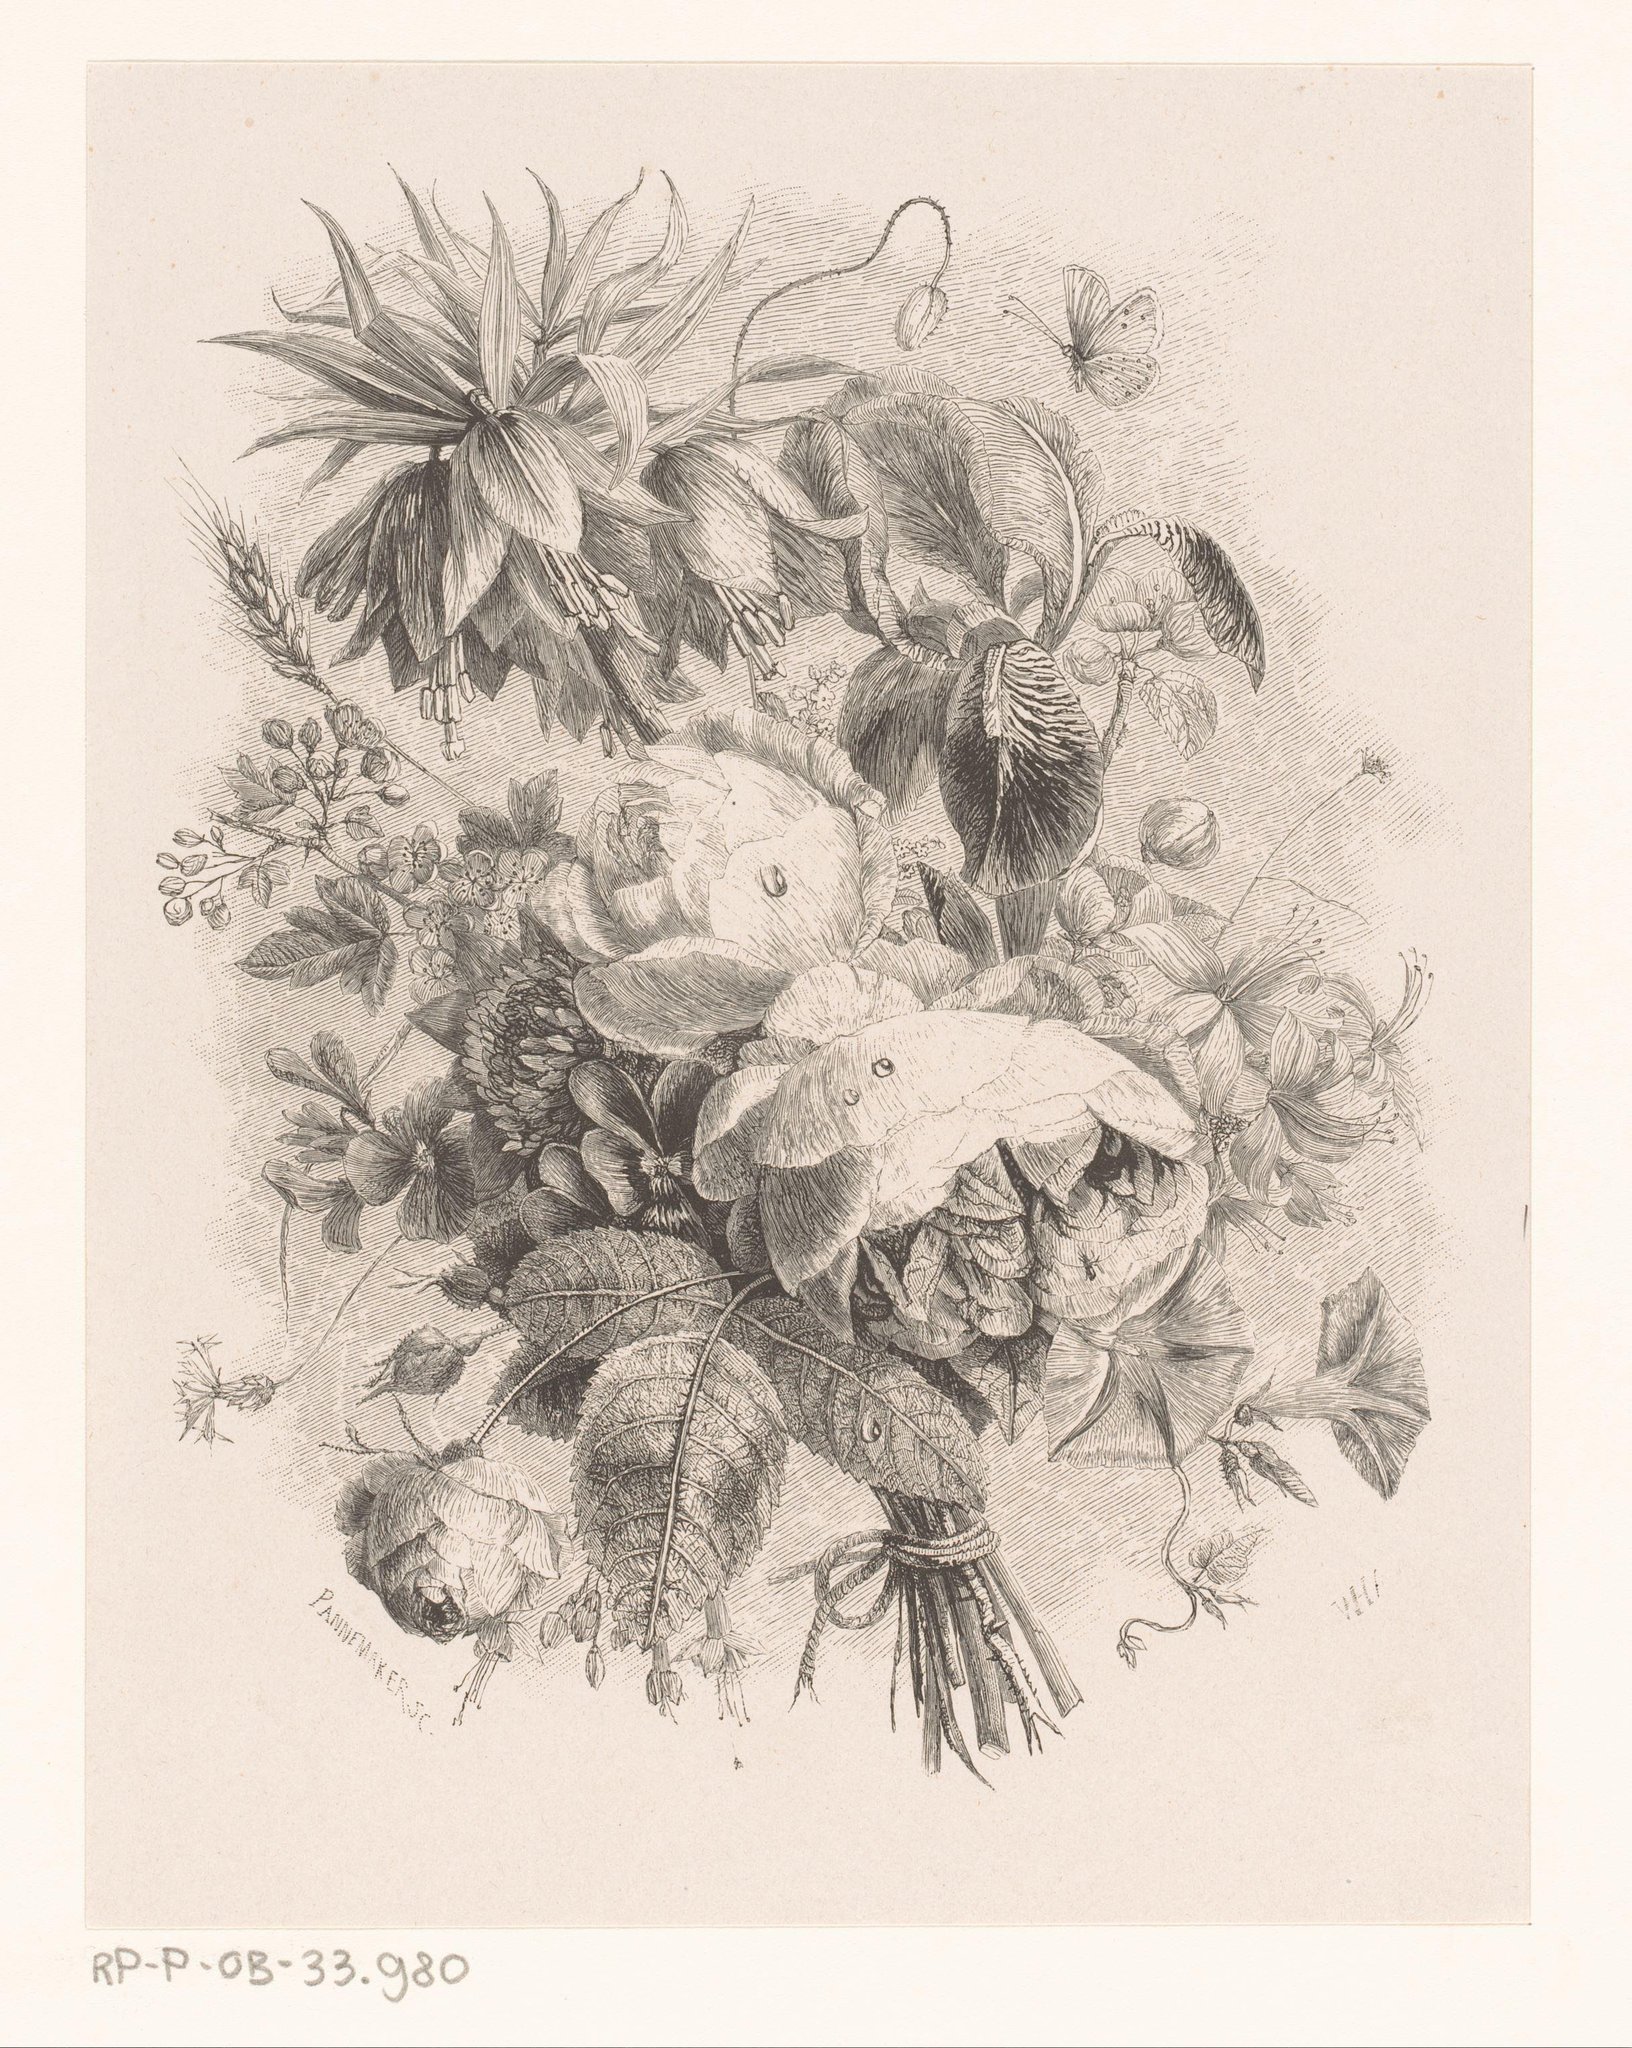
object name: print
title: Boeket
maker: adolphe françois pannemaker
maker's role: print maker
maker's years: 1822-1900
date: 1832-1900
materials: paper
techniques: engraving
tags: cut flowers; nosegay, bunch of flowers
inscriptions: collector's mark: Lugt 2228